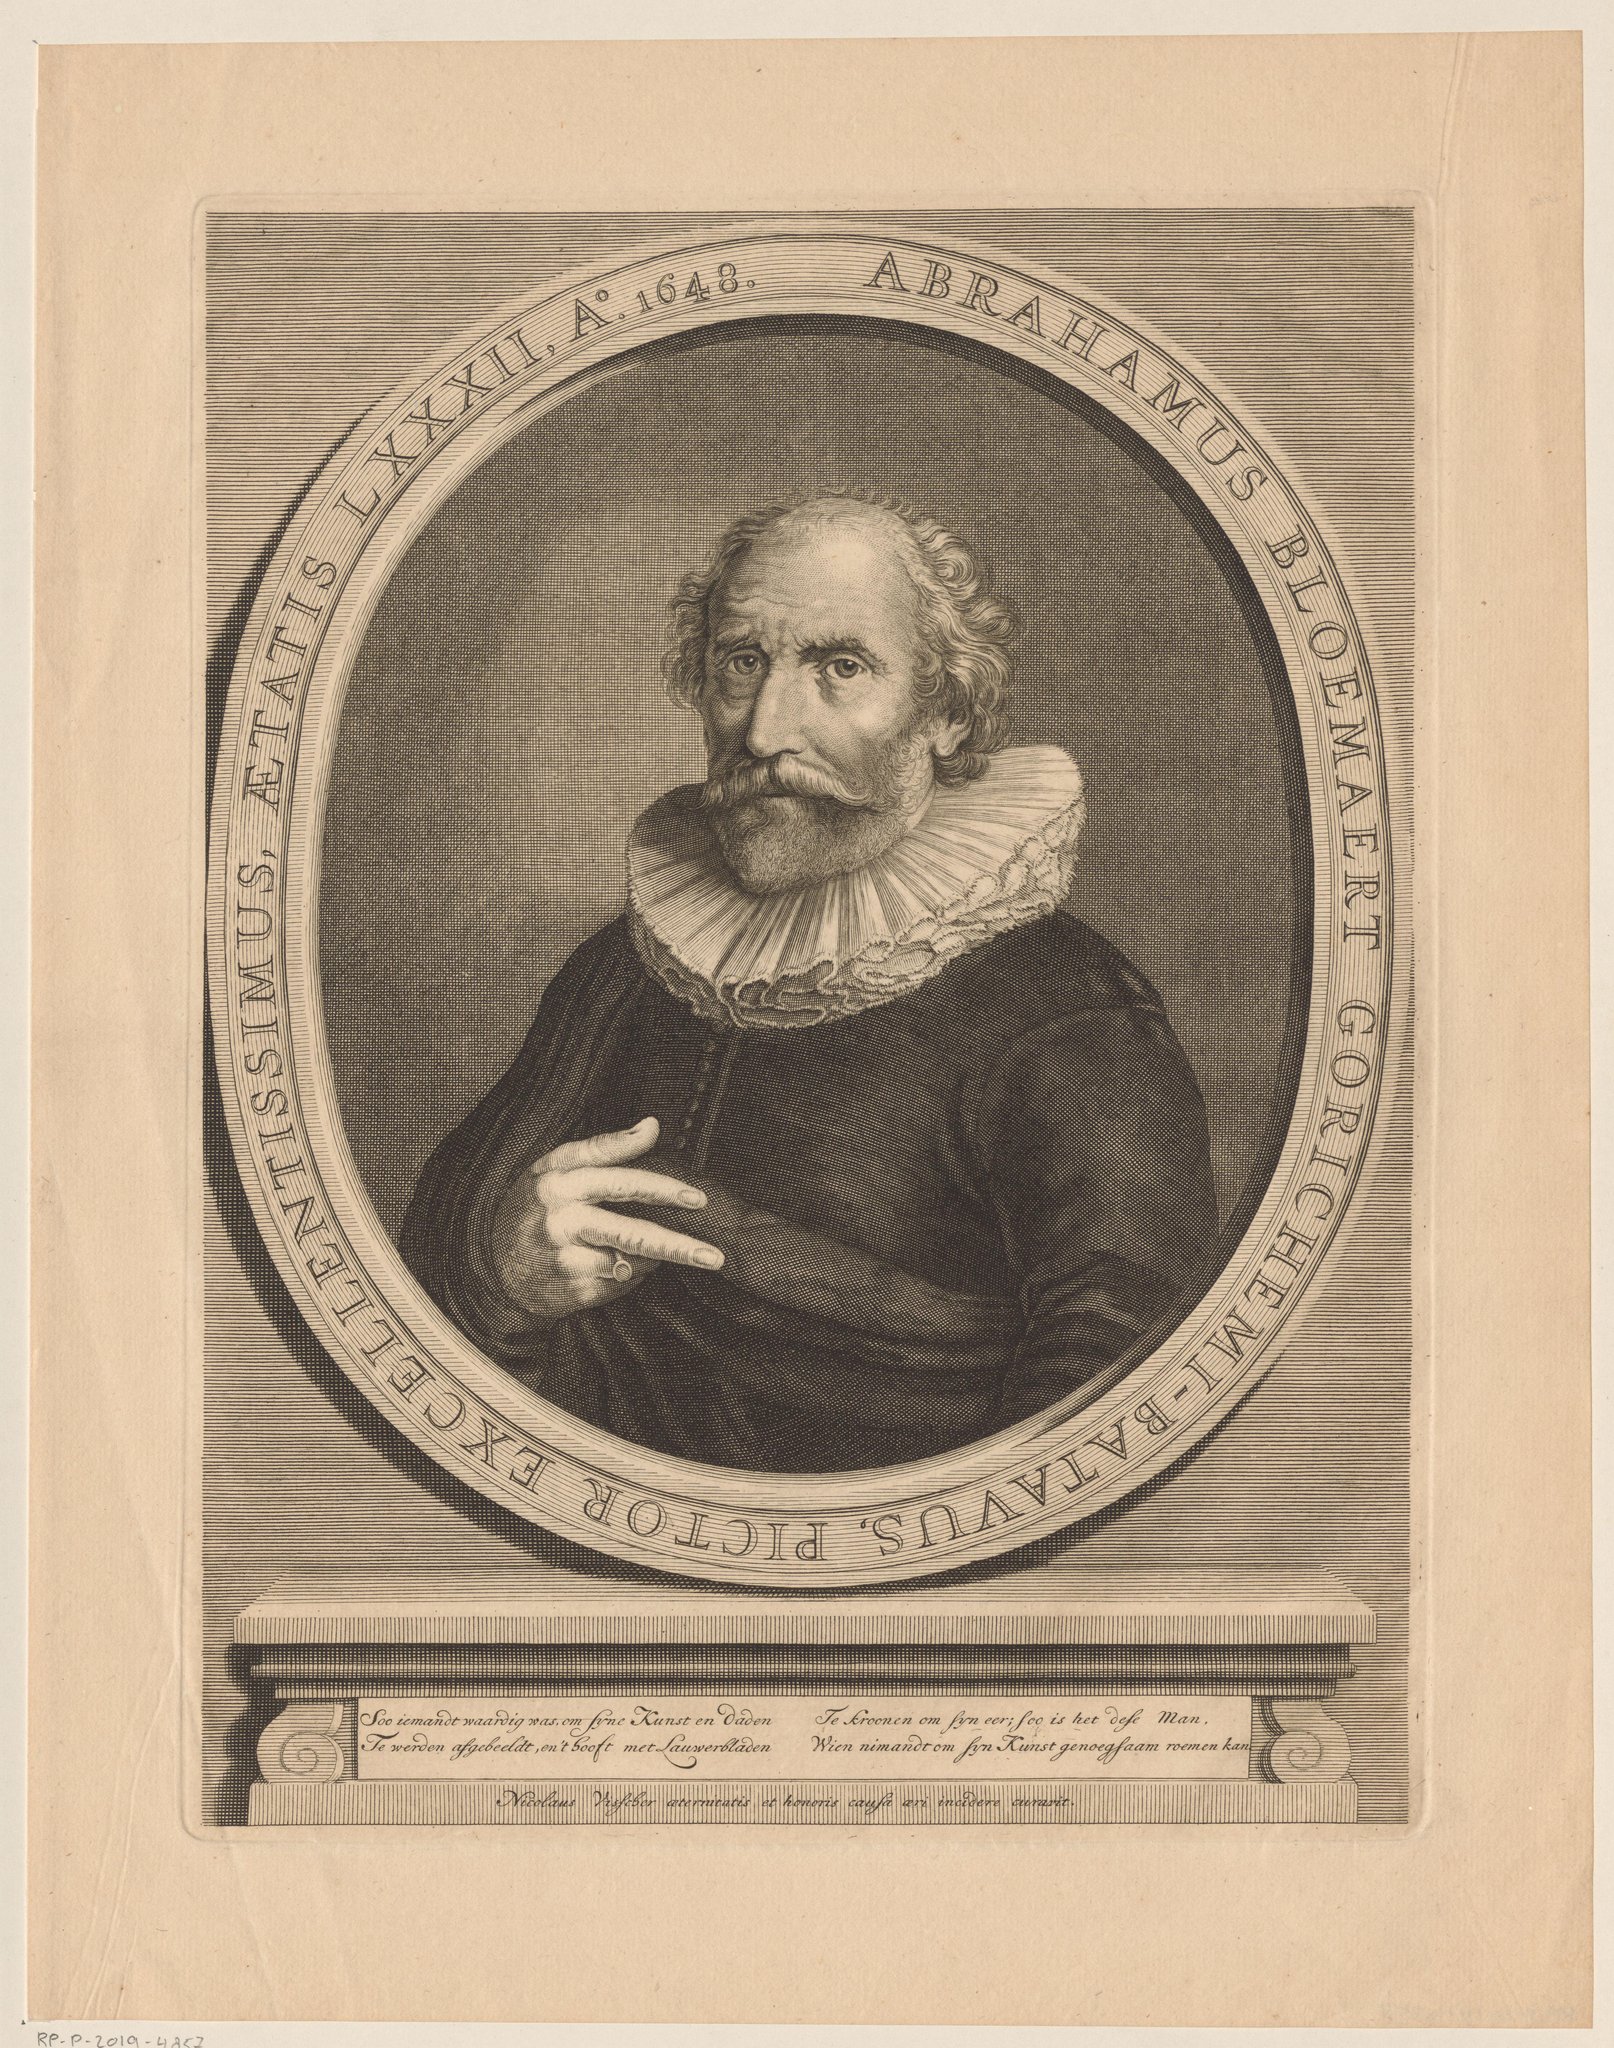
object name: print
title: Portret van Abraham Bloemaert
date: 1659-1731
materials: paper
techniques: engraving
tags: utrecht, painter, draughtsman, abraham bloemaert, historical persons, portrait, self-portrait of painter